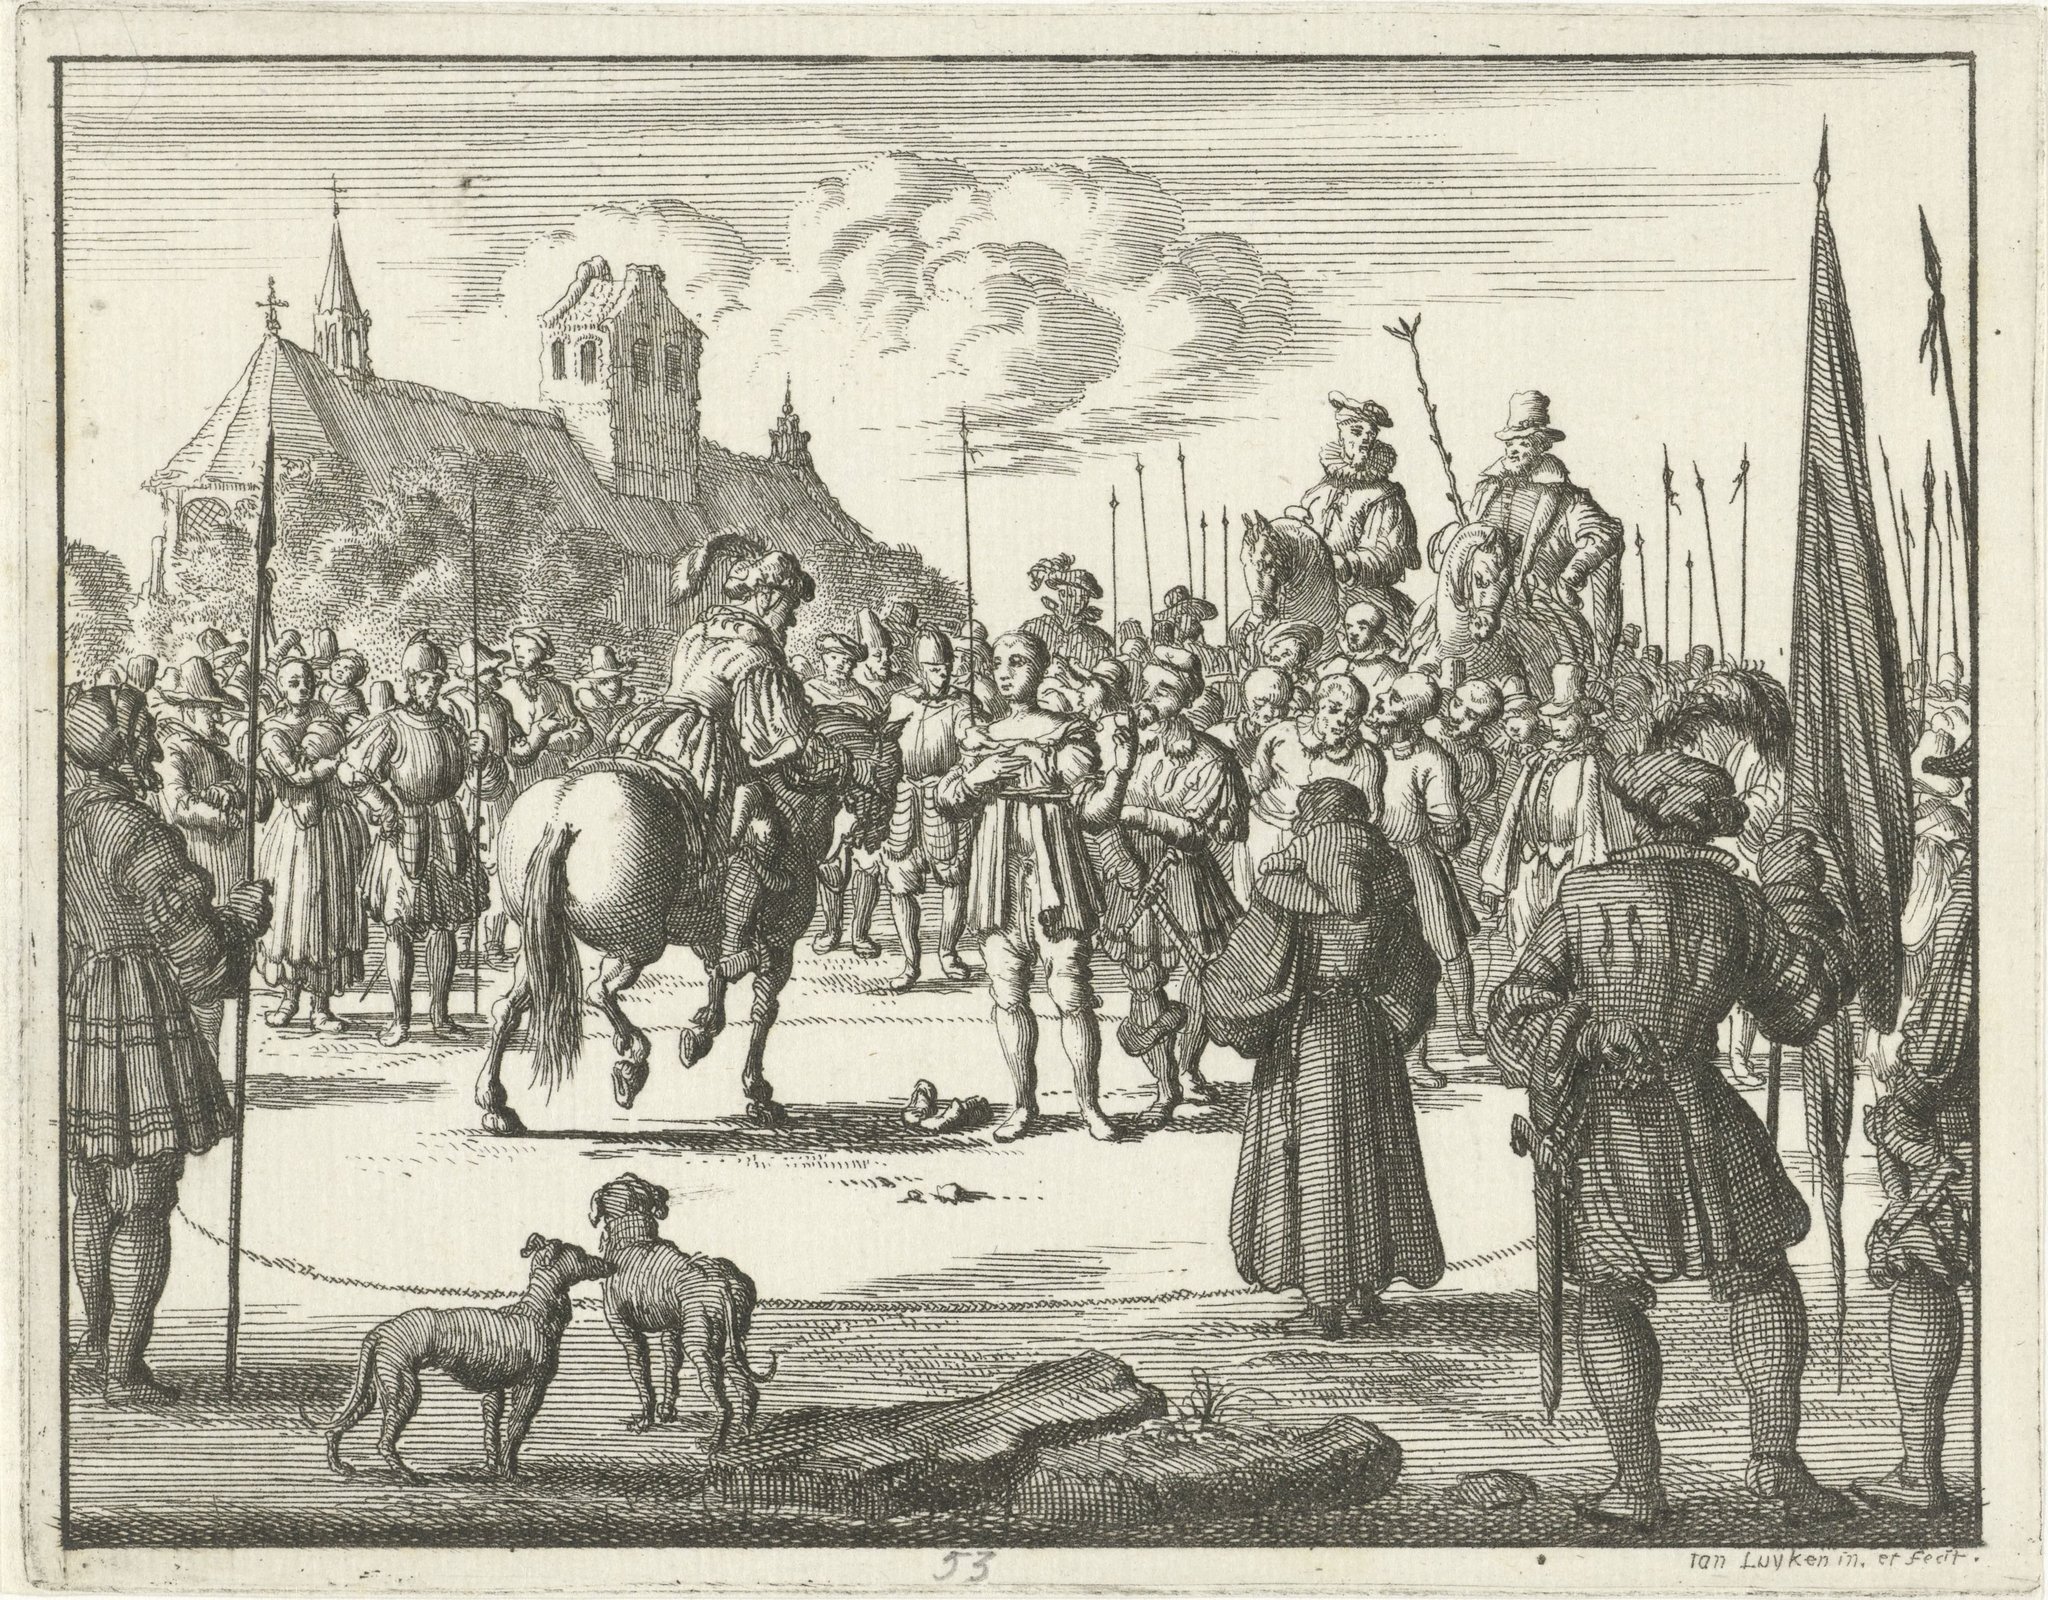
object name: book illustration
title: Martin Zehentmayer en zes andere wederdopers, toegesproken door een edelman, op weg naar hun executie te Gmünd, 1529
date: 1685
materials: paper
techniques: etching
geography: amsterdam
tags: persecution of heretics, (person under sentence of death) on the way to the scaffold or place of execution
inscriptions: collector's mark: Lugt 2228, number: ‘53’